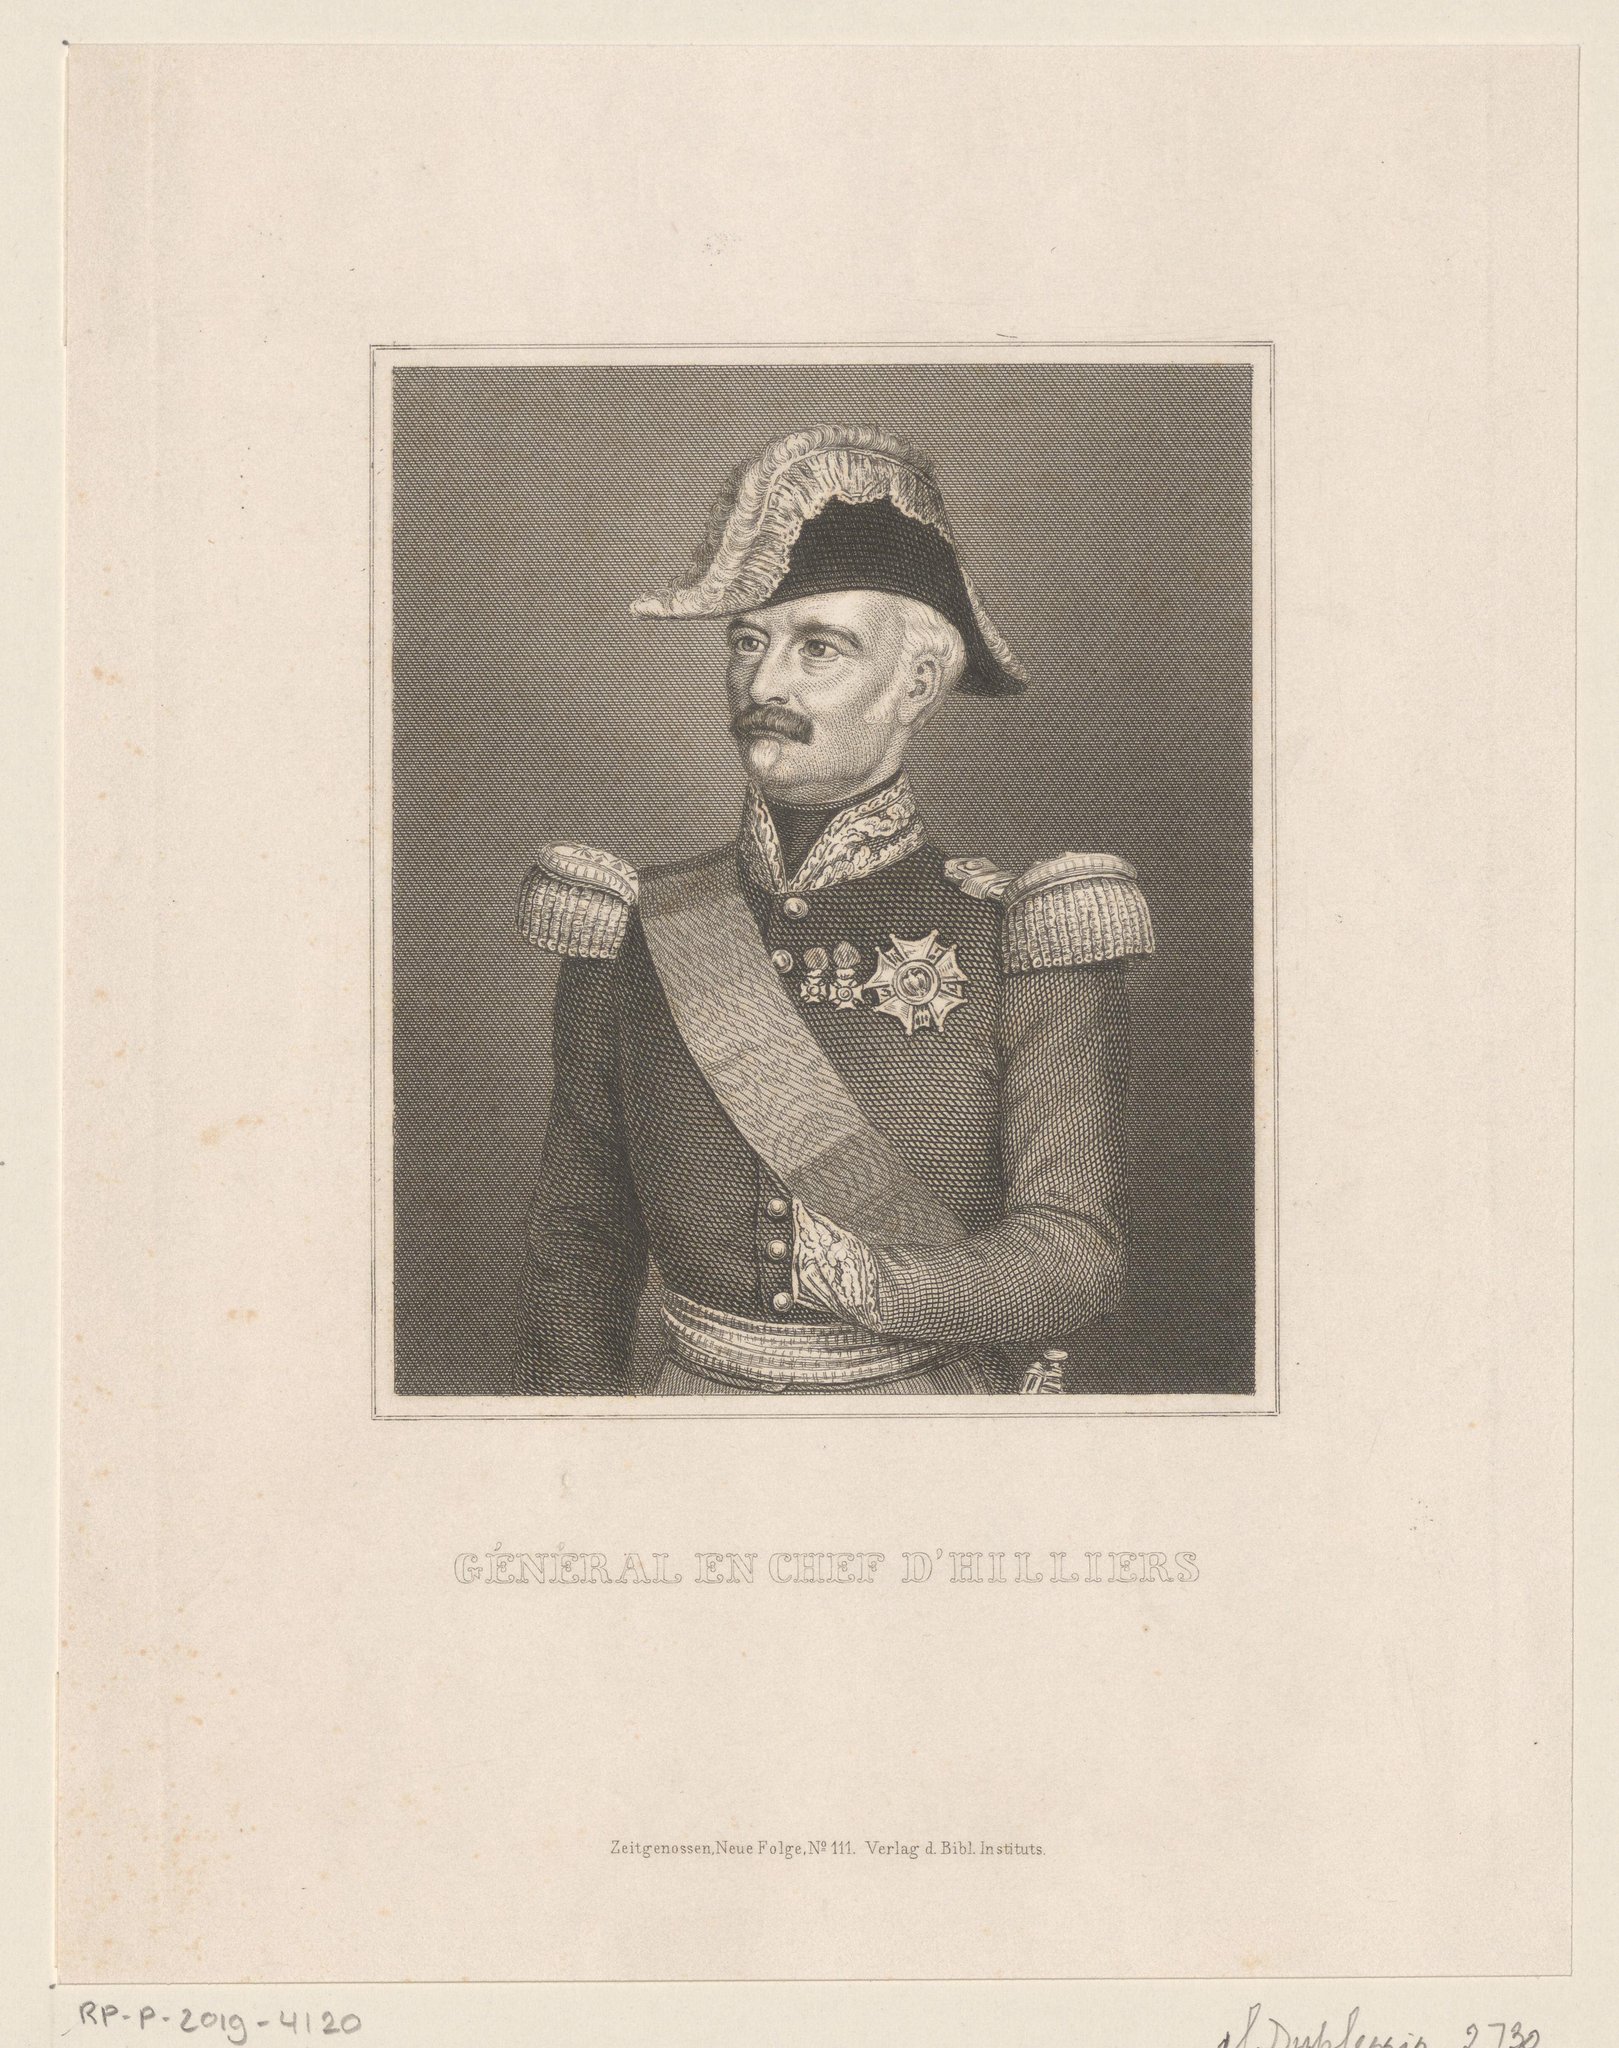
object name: print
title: Portret van Louis-Achille Baraguey d'Hilliers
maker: Anonymous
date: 1828-1874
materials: paper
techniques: engraving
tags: politician, historical persons